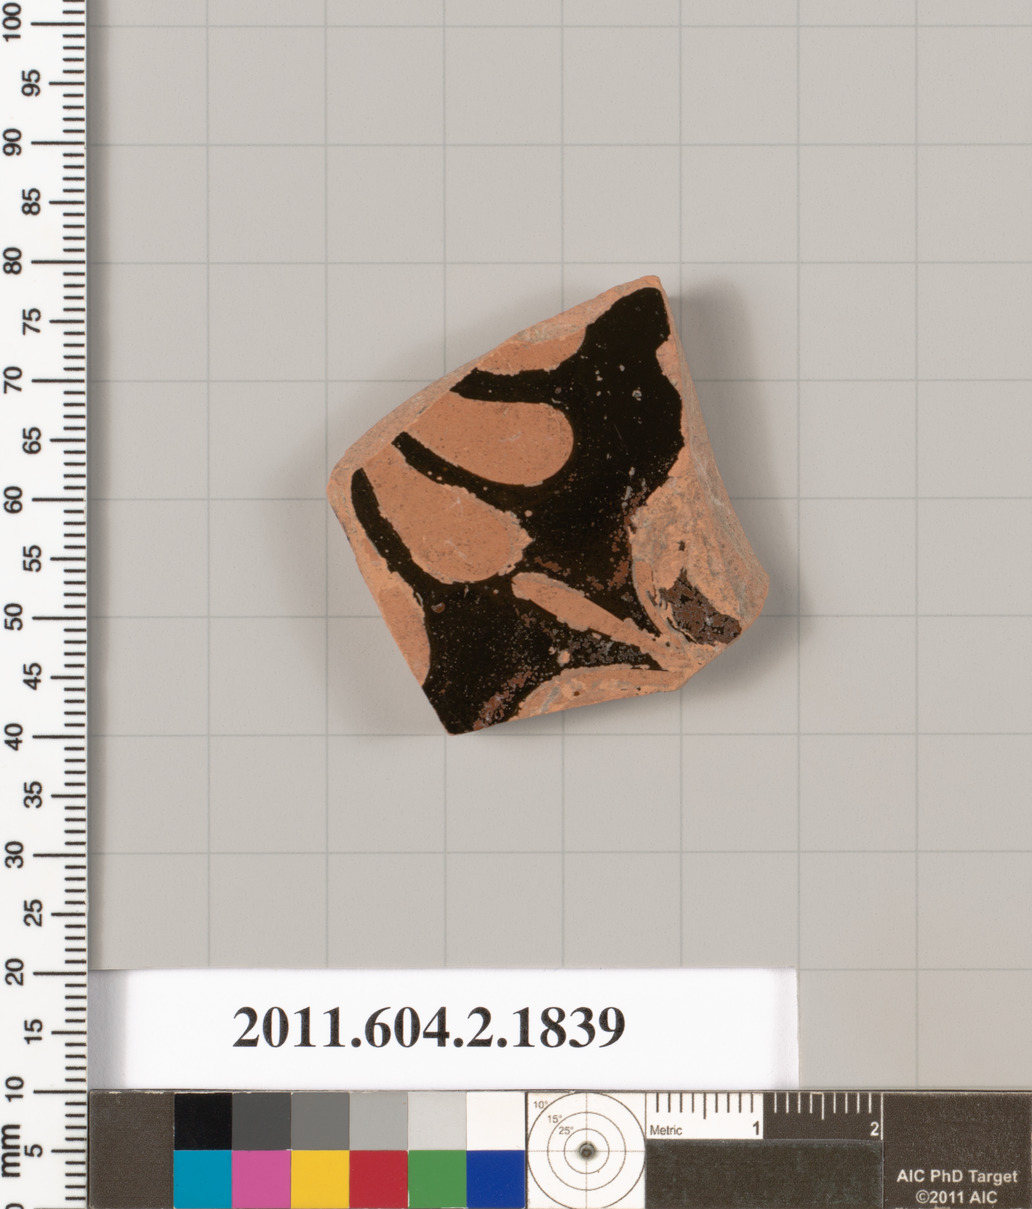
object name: skyphos fragment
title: Terracotta fragment of a skyphos (deep drinking cup)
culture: greek, attic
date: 450-426 BCE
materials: terracotta